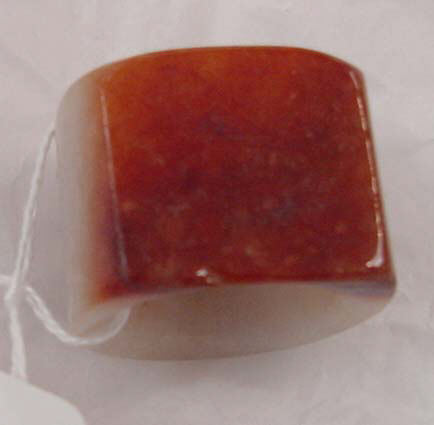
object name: ring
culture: chinese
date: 1801-1900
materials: jade